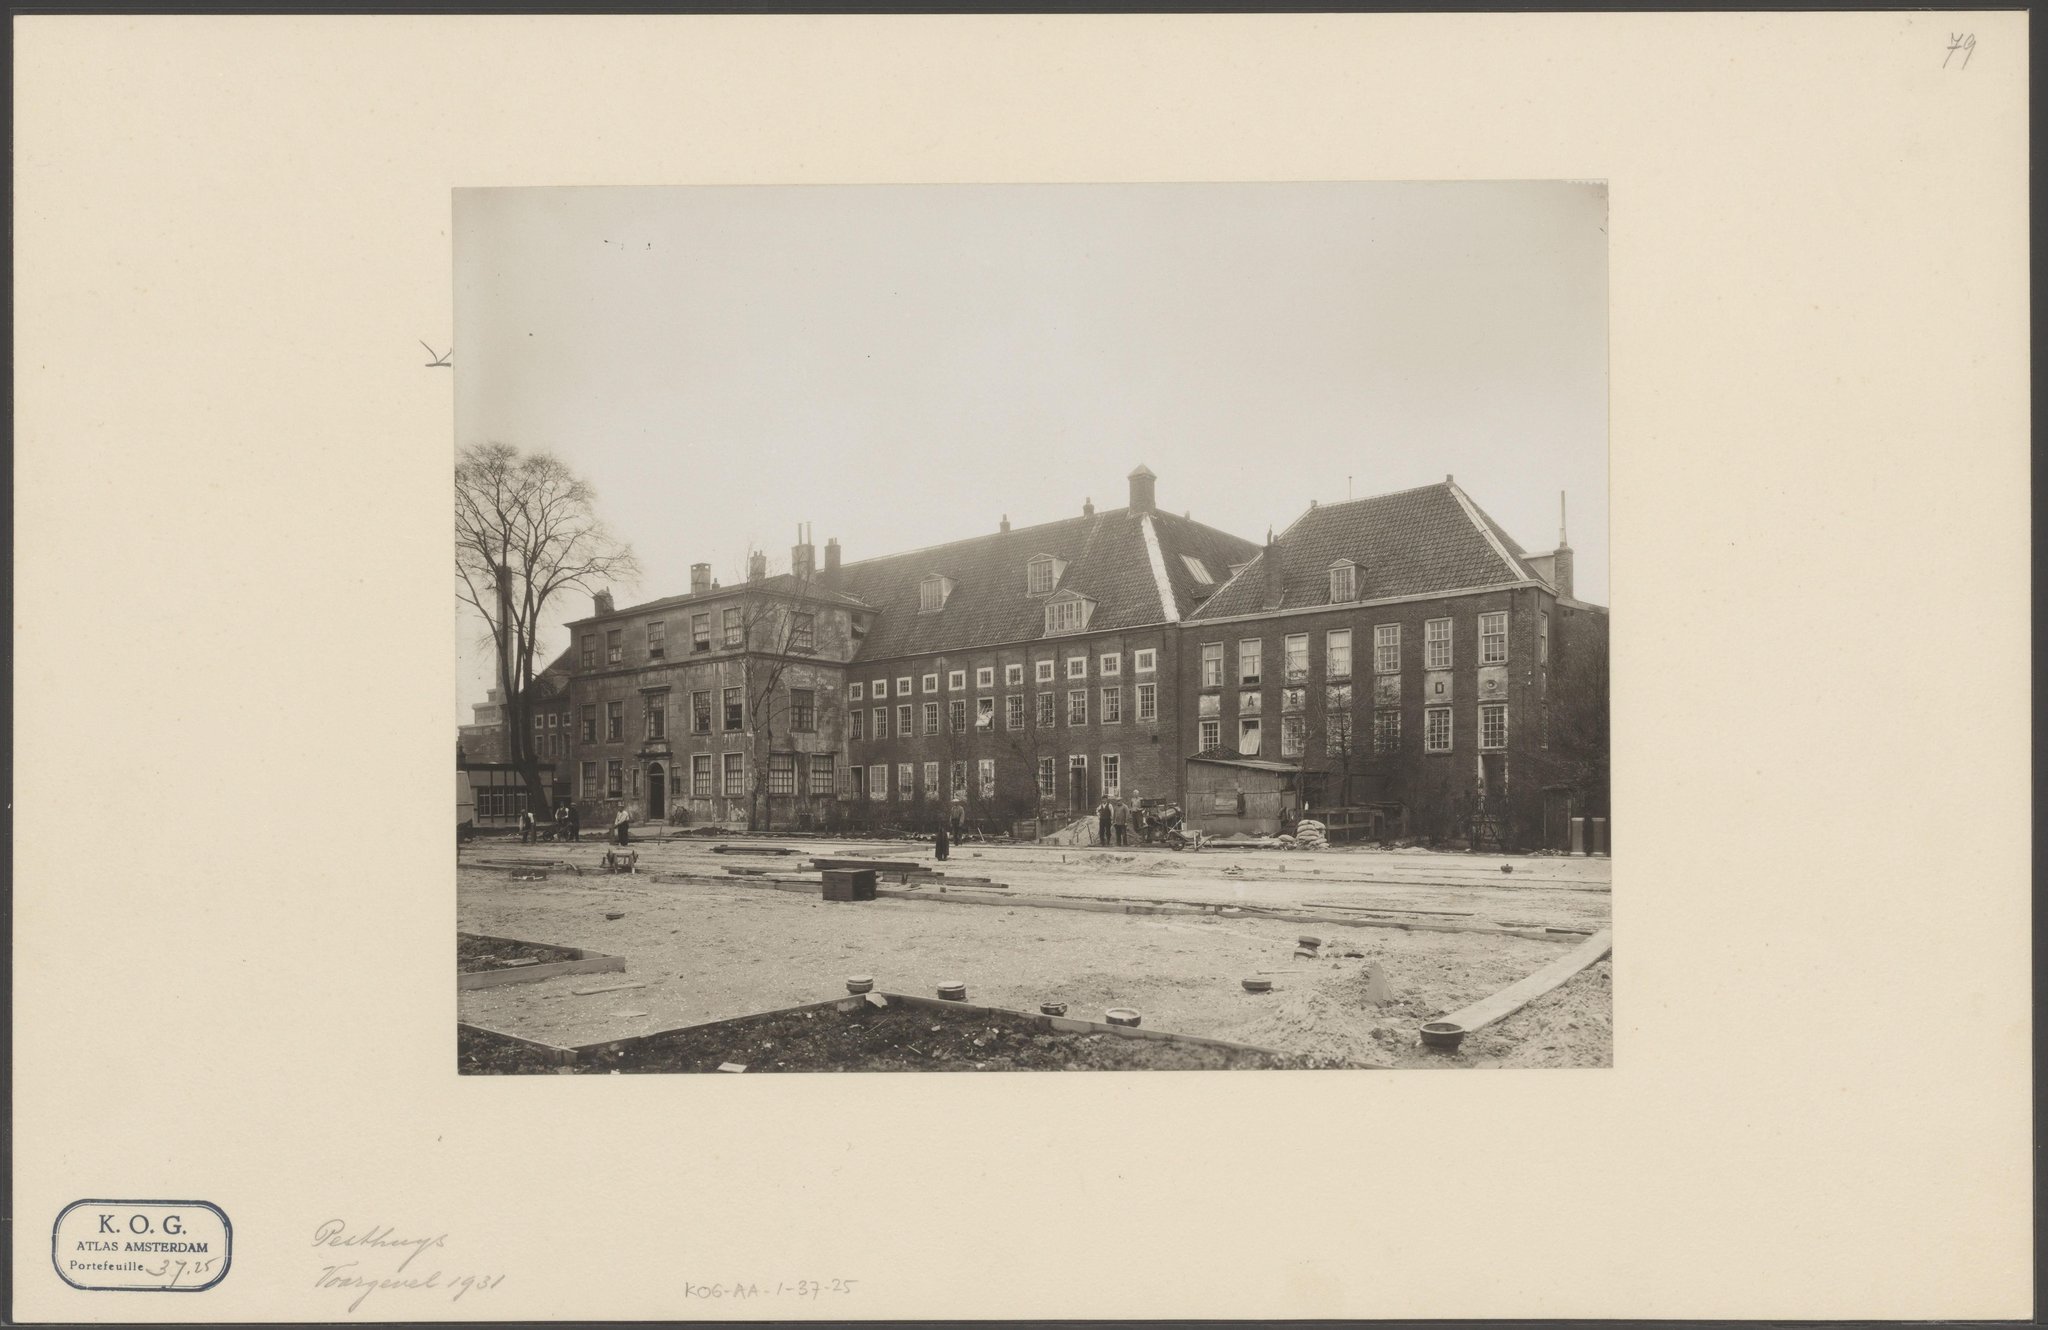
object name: photograph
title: Gezicht op de voorzijde van het Buitengasthuis te Amsterdam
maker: Anonymous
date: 1931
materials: paper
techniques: gelatin silver print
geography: amsterdam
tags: hospital, front façade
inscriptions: collector's mark: Lugt 1641b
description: Onderwerpsrubriek binnen de Atlas Amsterdam: Armwezen en liefdadige instellingen: I. Stadsinrichtingen: Buitengasthuis (Pesthuis).